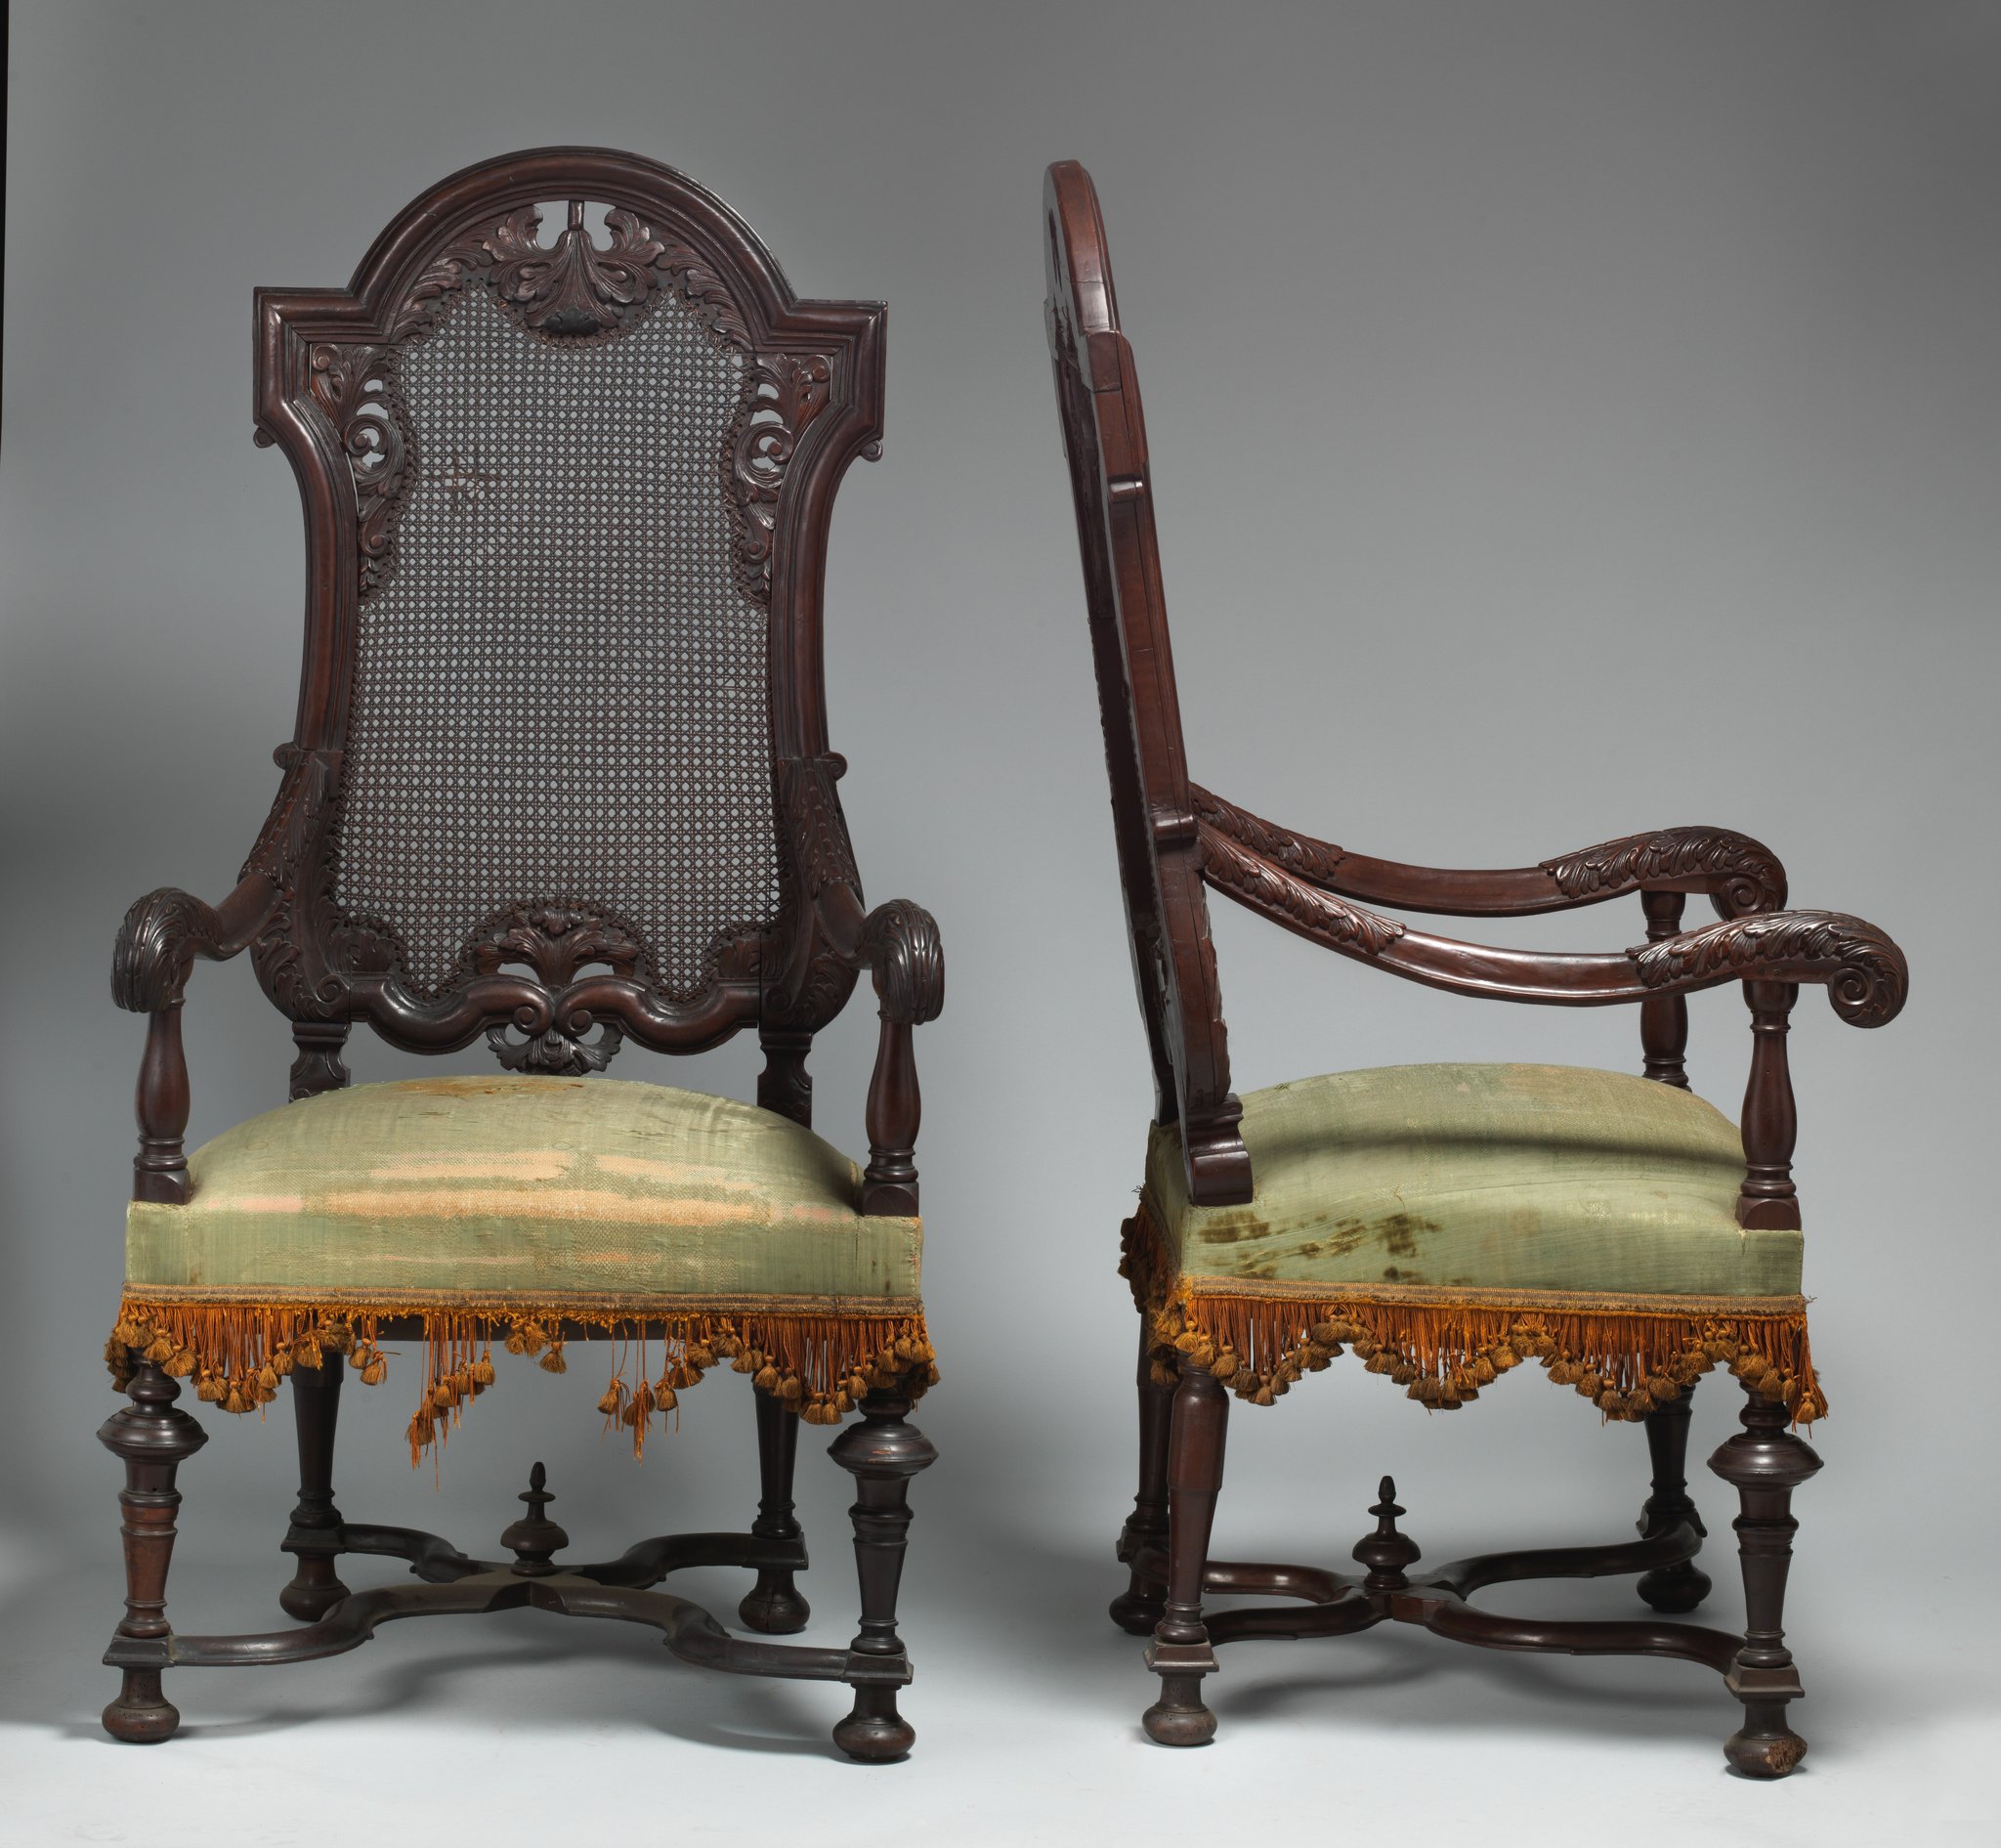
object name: armchair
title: Armchair (one of a pair)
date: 1689-1702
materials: wood